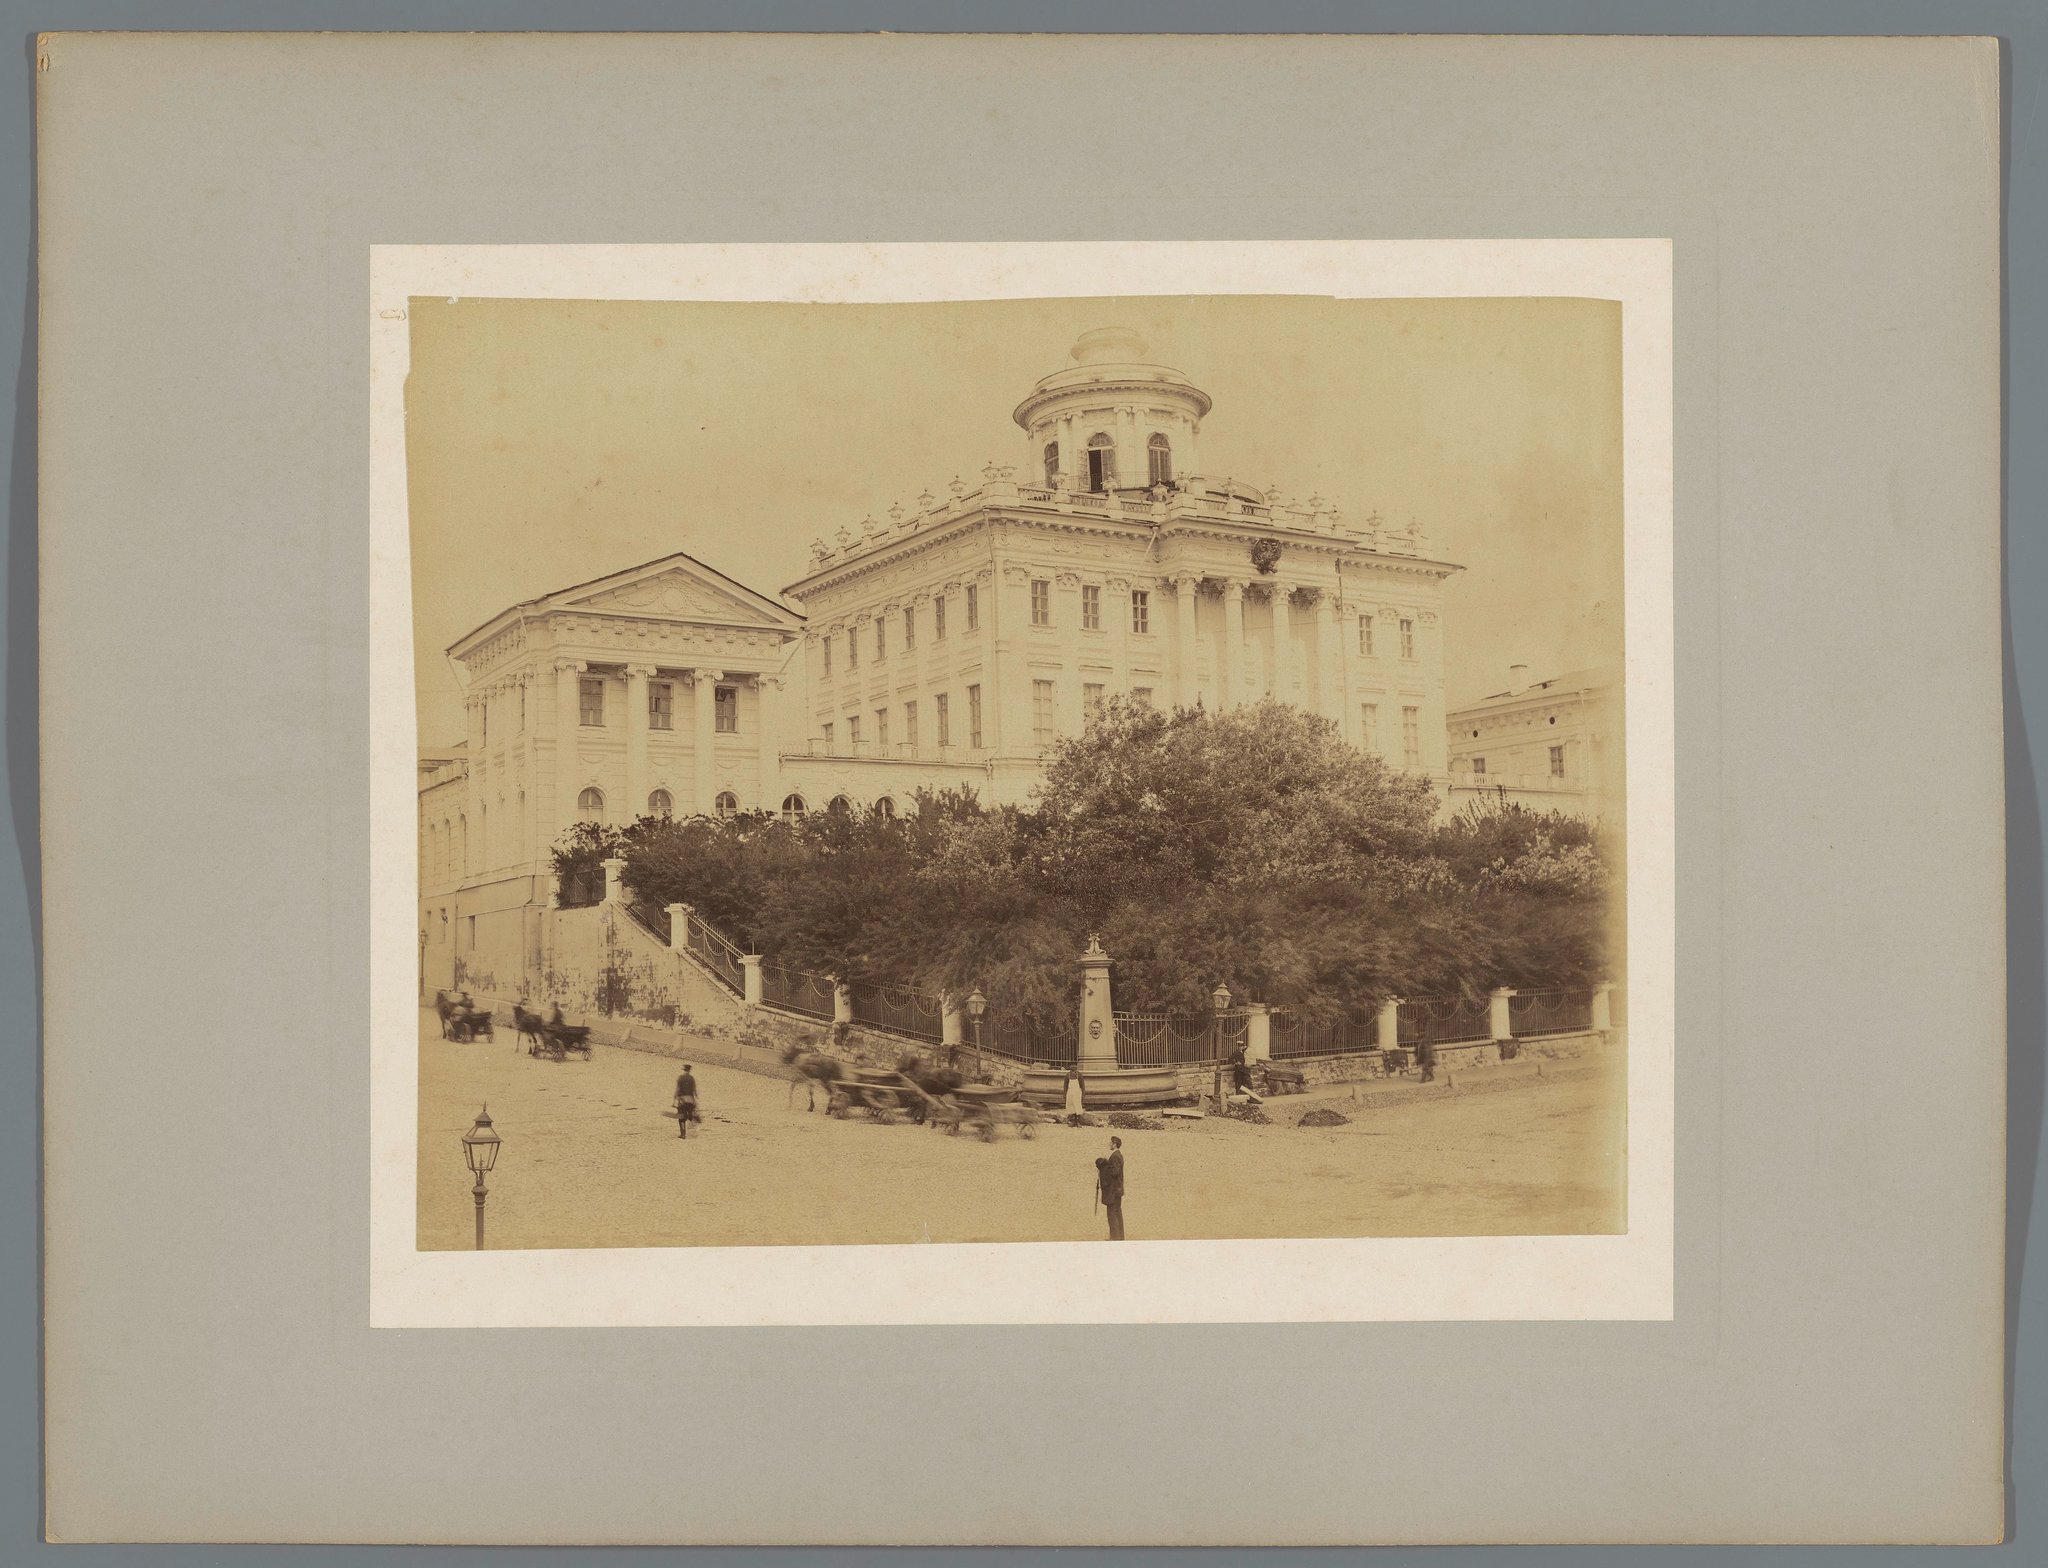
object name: photograph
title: Rumjantsew museum, Moskou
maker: Anonymous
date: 1860-1890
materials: cardboard, paper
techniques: albumen print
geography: moscow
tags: permanent exhibition, museum